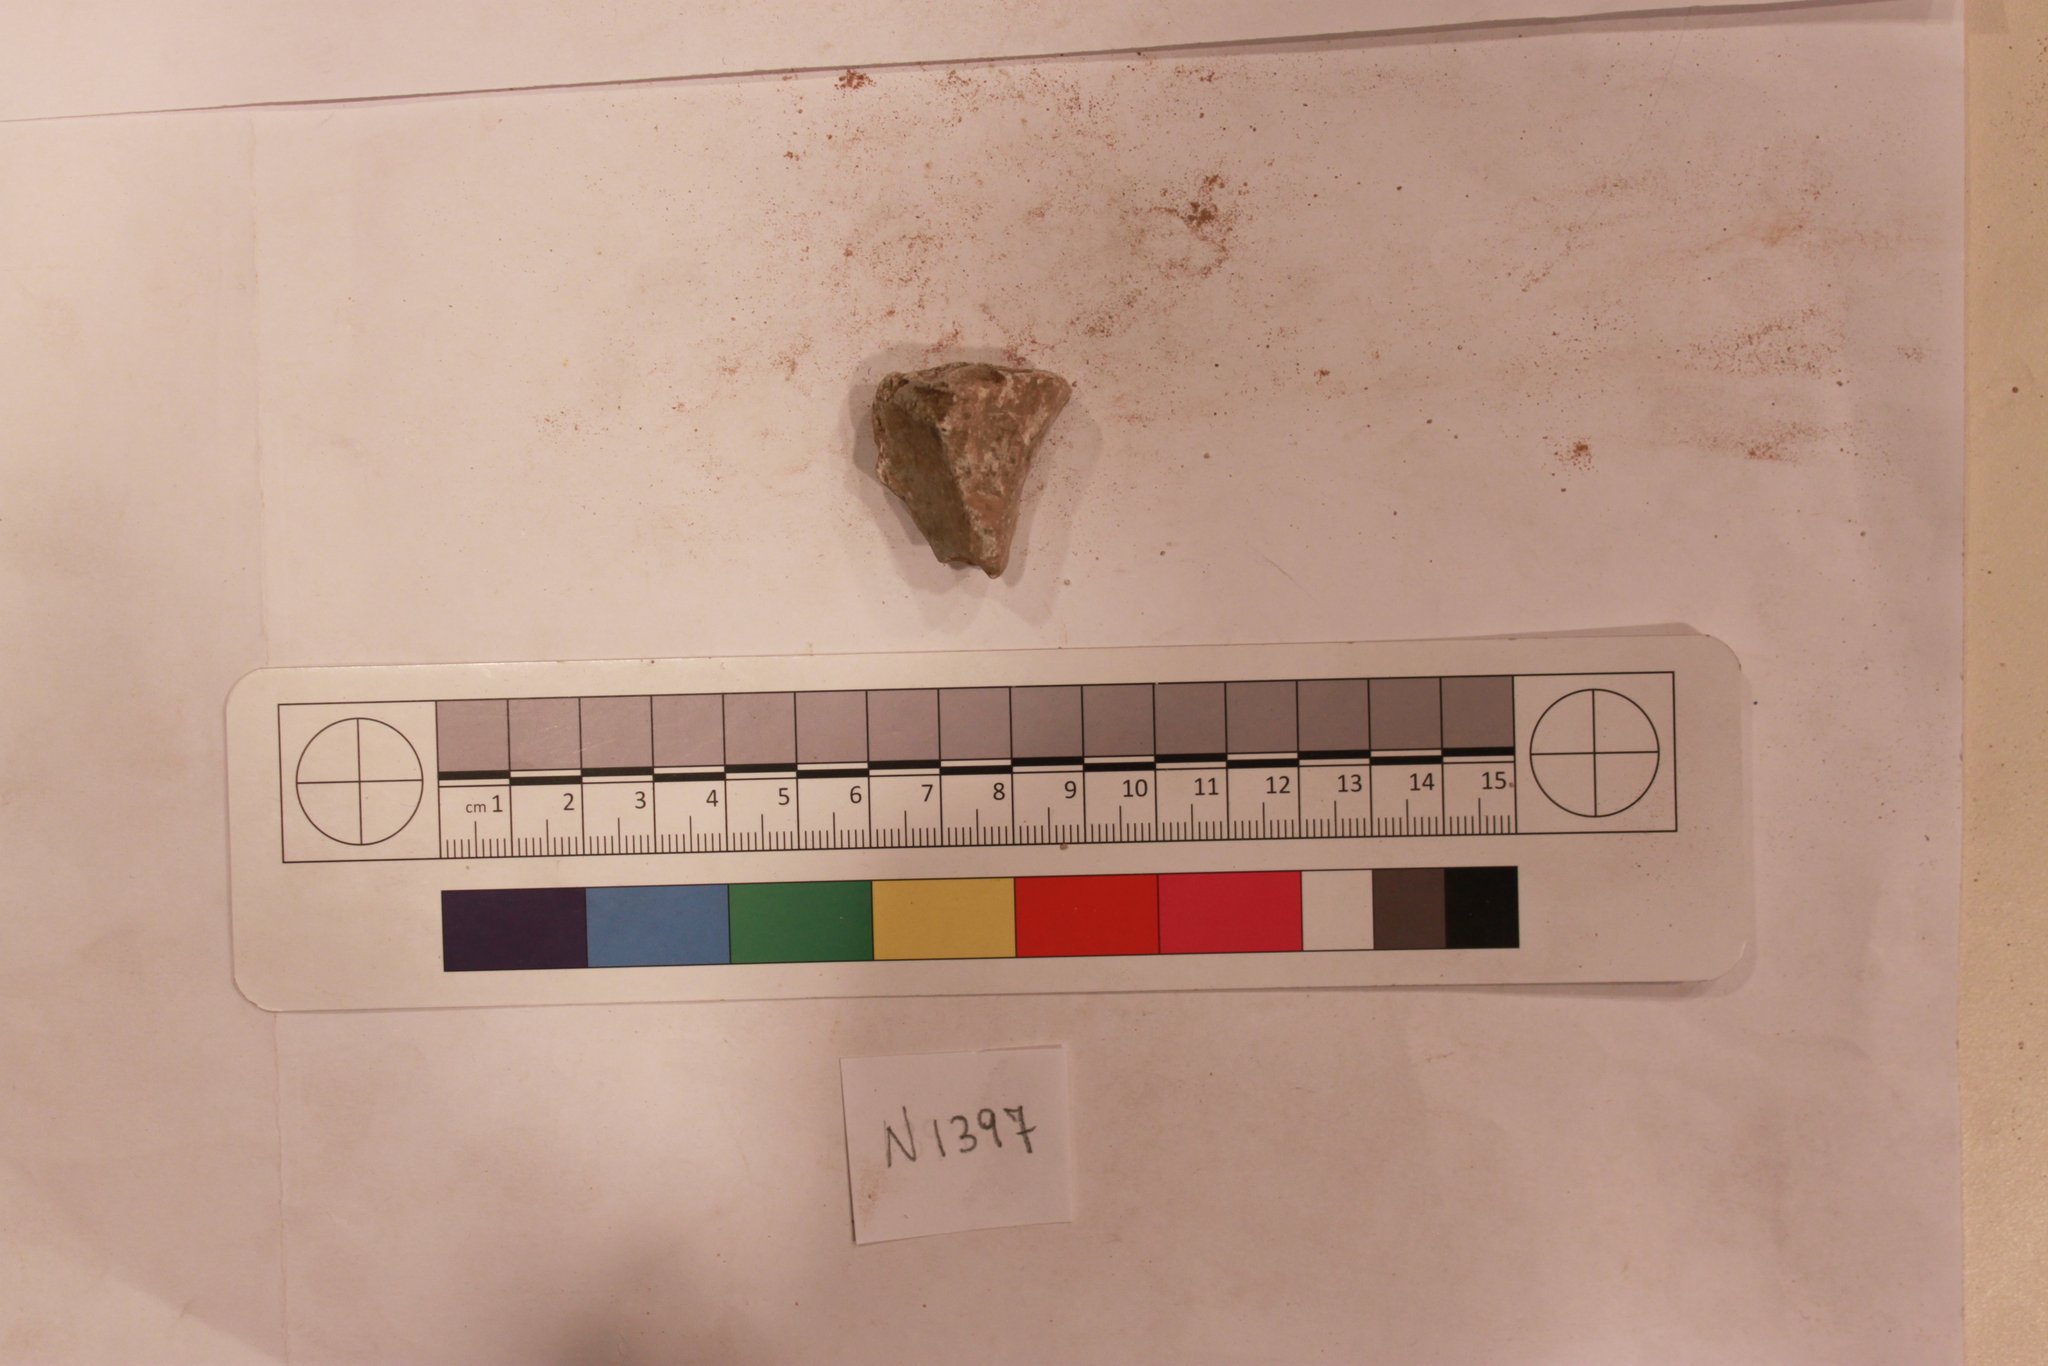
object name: fragment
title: Stucco Fragment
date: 701-1200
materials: plaster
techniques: carving, painting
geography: iran